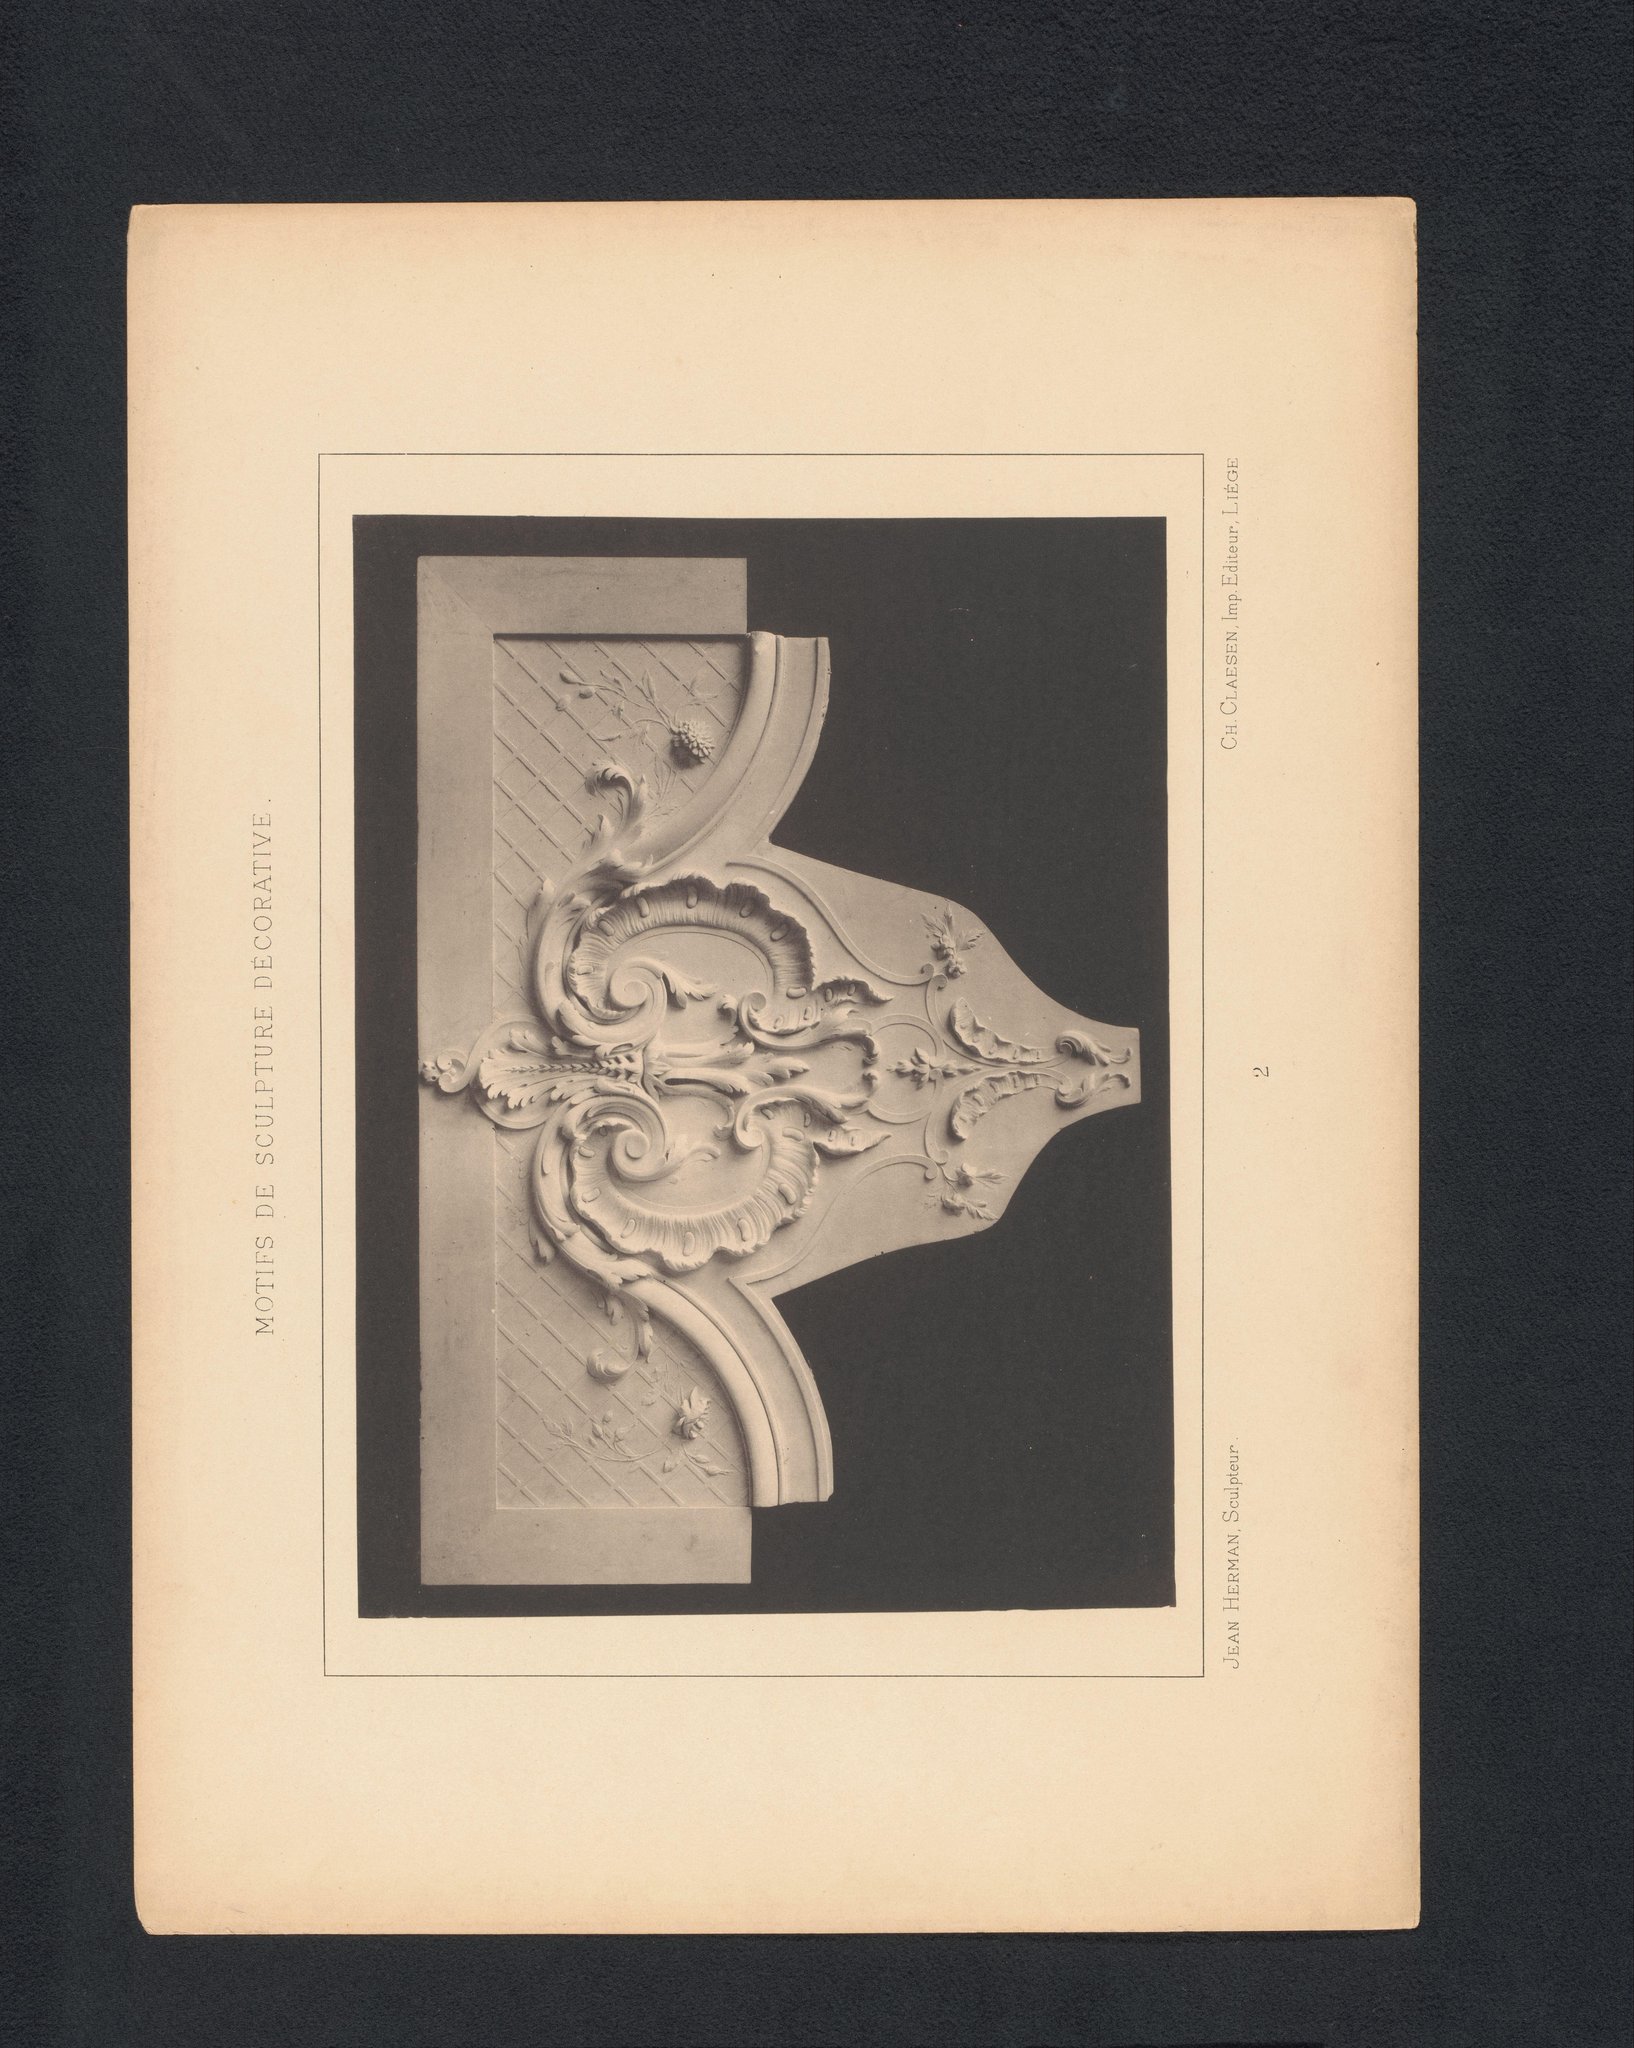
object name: photomechanical print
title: Motifs de sculpture décorative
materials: paper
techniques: photograph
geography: liège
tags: ornament derived from plant forms, sculpture (+ relief ~ sculpture)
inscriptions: number: ‘2’, inscription: ‘Jean Herman, Sculpteur.’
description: Deze prent maakt deel uit van een omslag met 28 prenten en een titelblad.